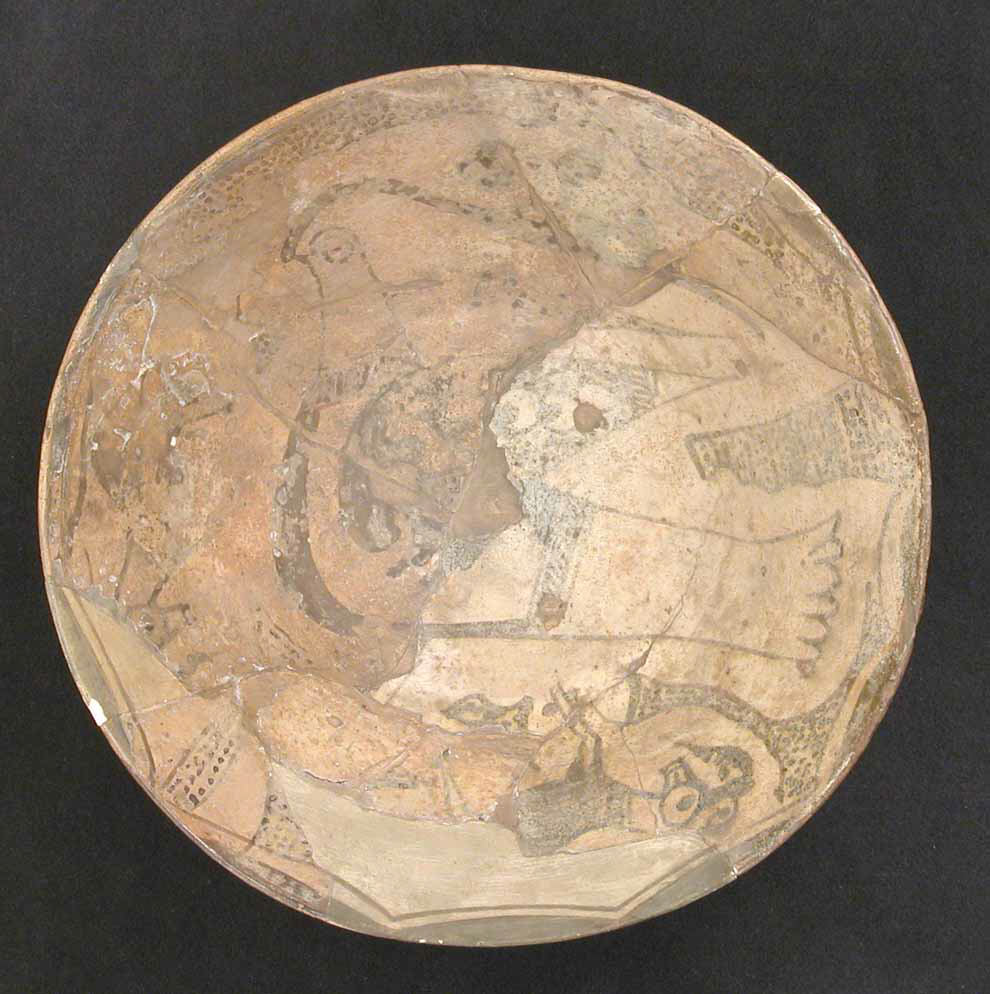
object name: bowl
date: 801-900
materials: earthenware, glaze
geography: iran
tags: birds